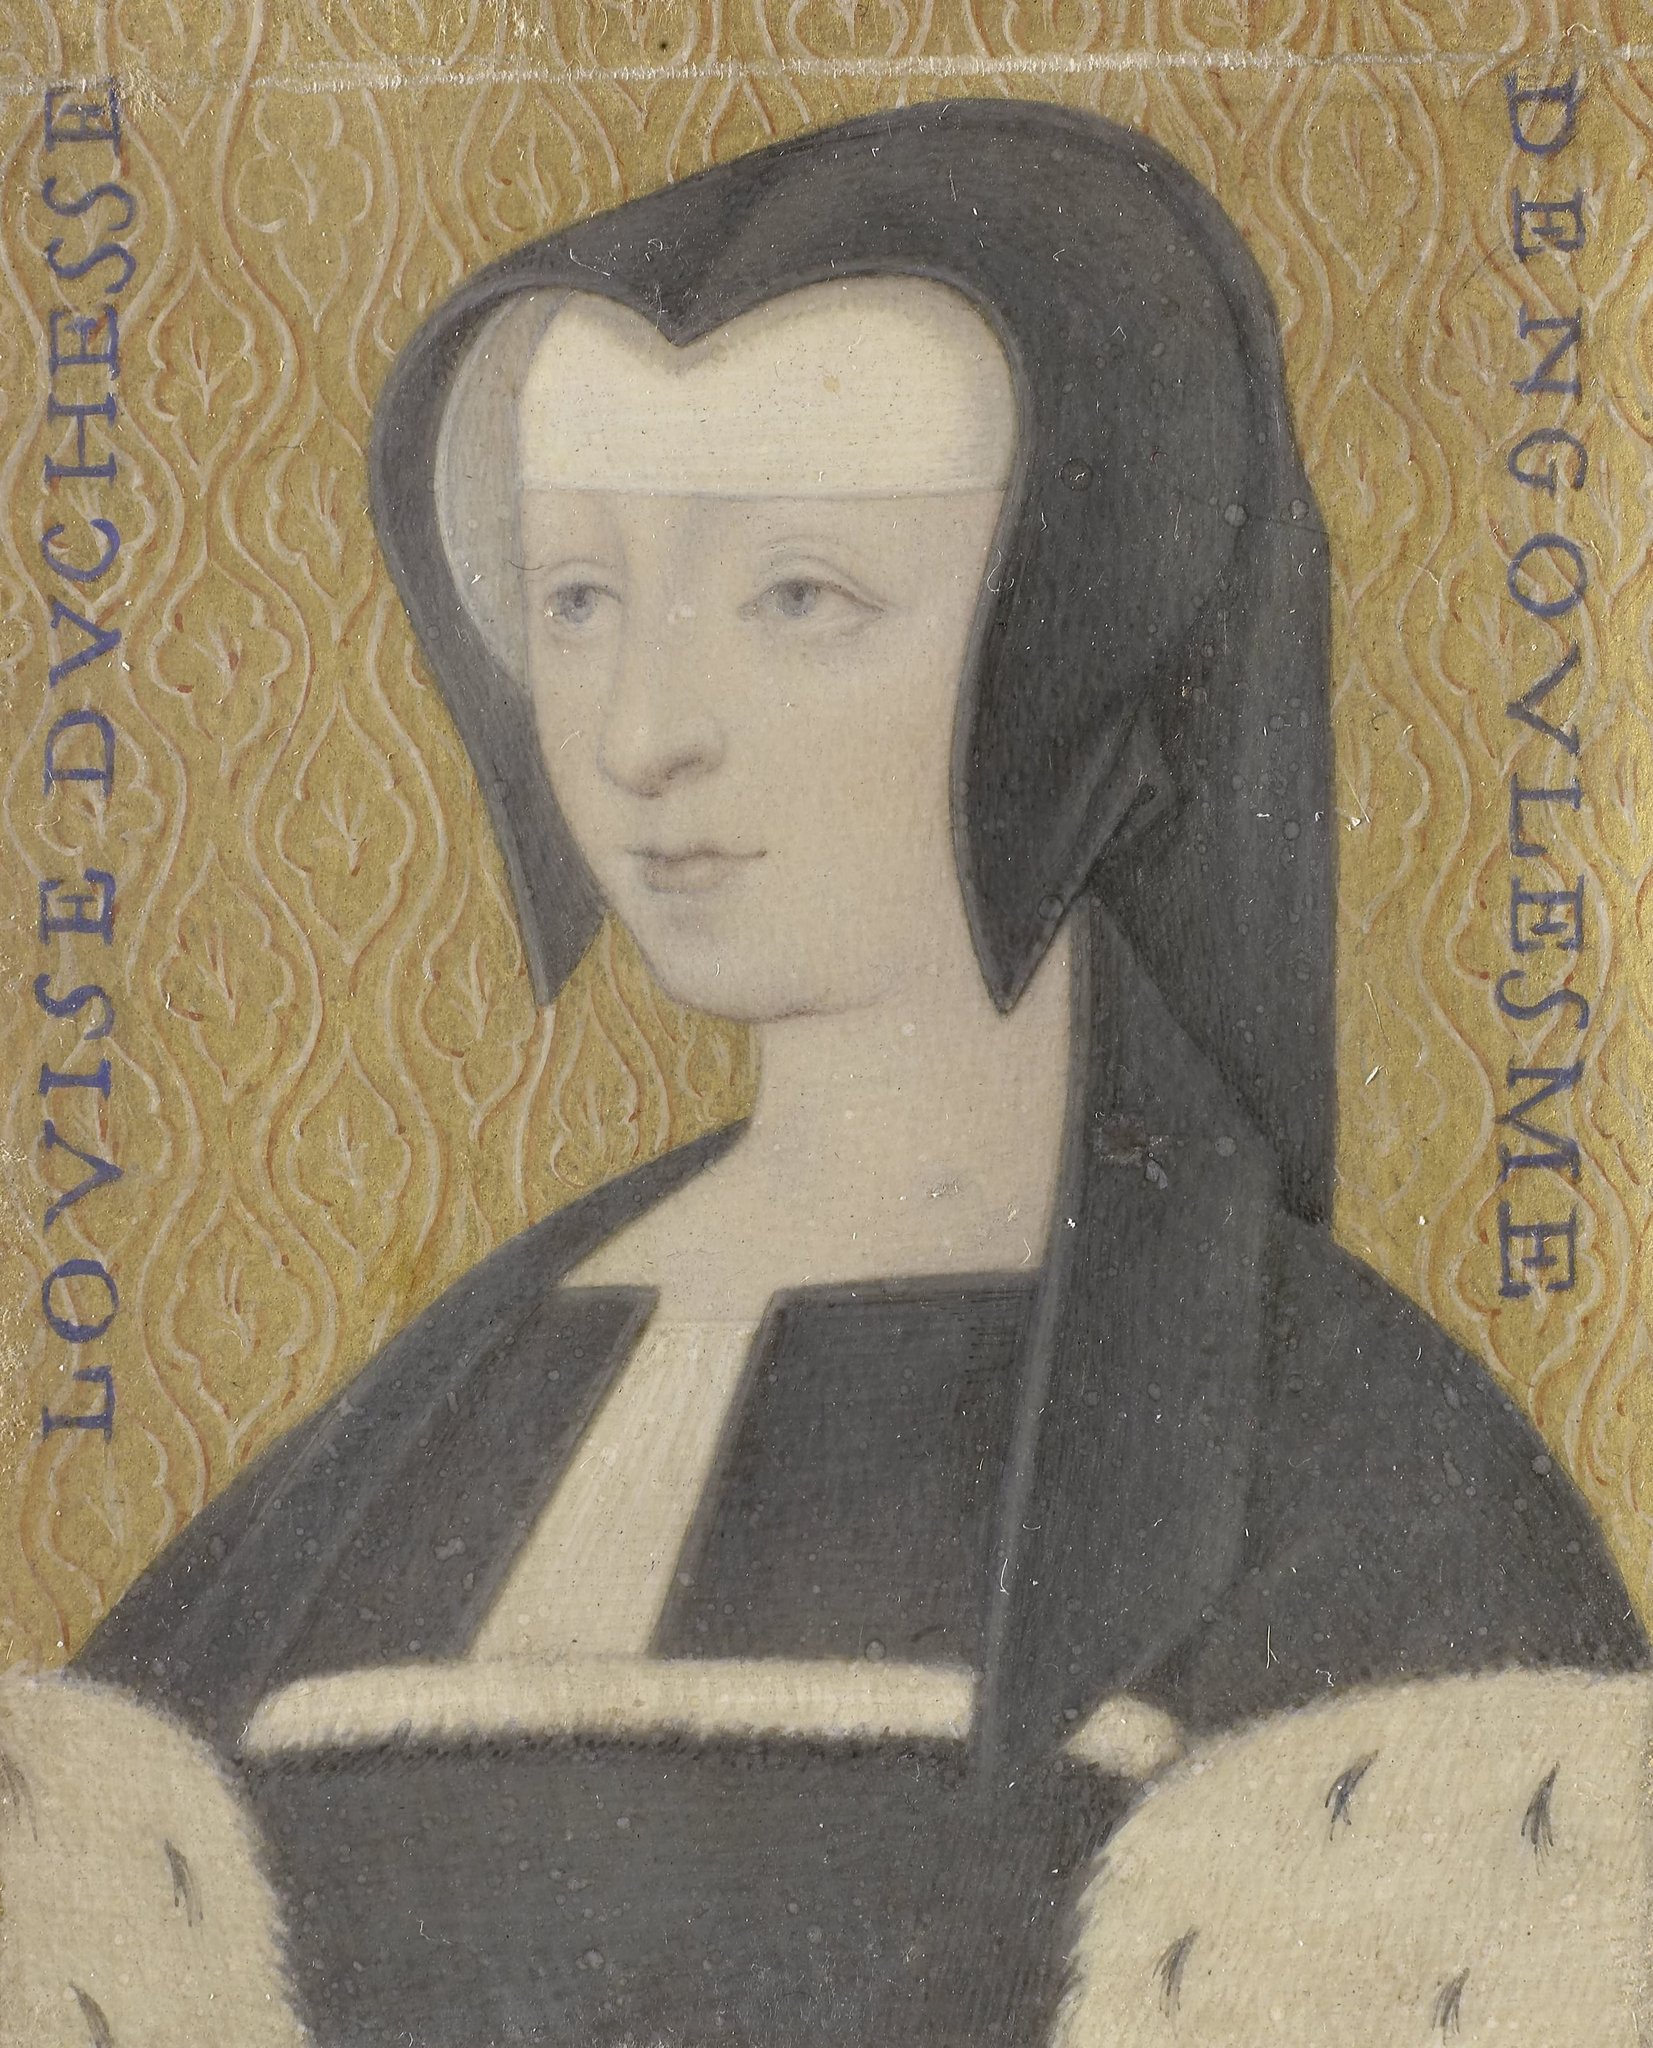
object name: painting, miniature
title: Louise van Savoye (1467-1531), hertogin van Angoulême, moeder van Frans I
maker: Anonymous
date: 1700-1799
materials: glass, metal, parchment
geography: france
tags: prinses, regentes, louise van savoye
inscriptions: inscription: ‘Louise Duchesse d'Engoulesme’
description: Portret van Louise van Savoye (1467-1531), hertogin van Angoulême, moeder van Frans I. Ten halven lijve, naar links. Wellicht naar een origineel door François Clouet. Onderdeel van de collectie portretminiaturen.